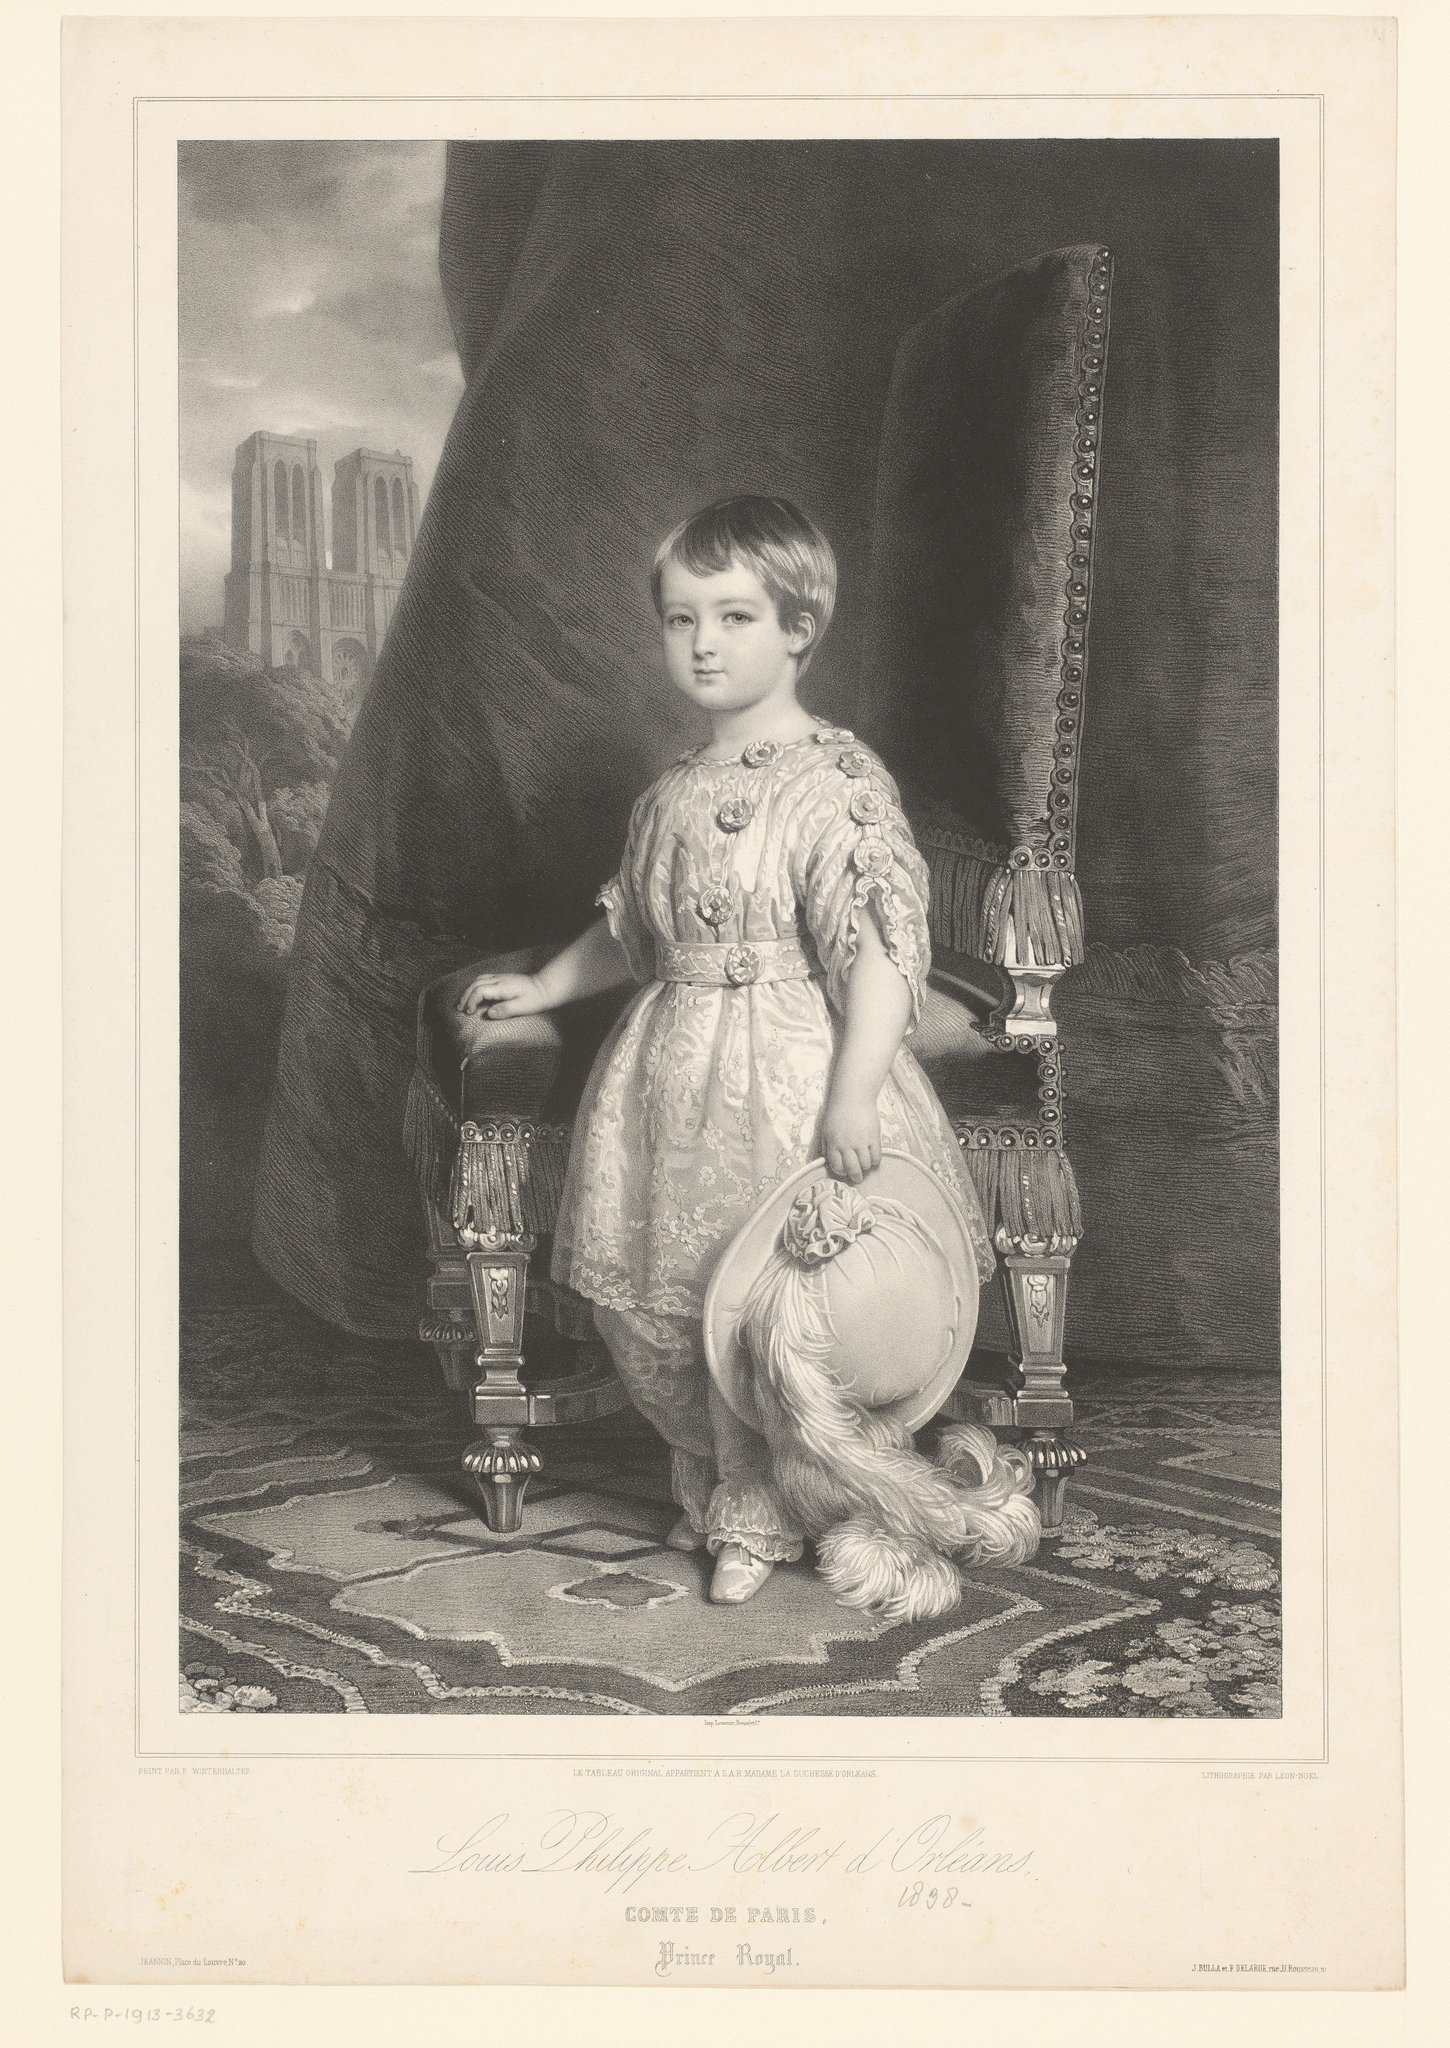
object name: print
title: Portret van Louis Philippe Albert d'Orleans, graaf van Parijs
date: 1842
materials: paper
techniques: lithograph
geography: paris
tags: paris, earl, fashion, clothing, armchair, seat, head-gear, historical persons, ruler, sovereign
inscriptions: check stamp: Lugt 1397c, check stamp: Lugt 4986, collector's mark: Lugt 2233, check stamp: Lugt 4979